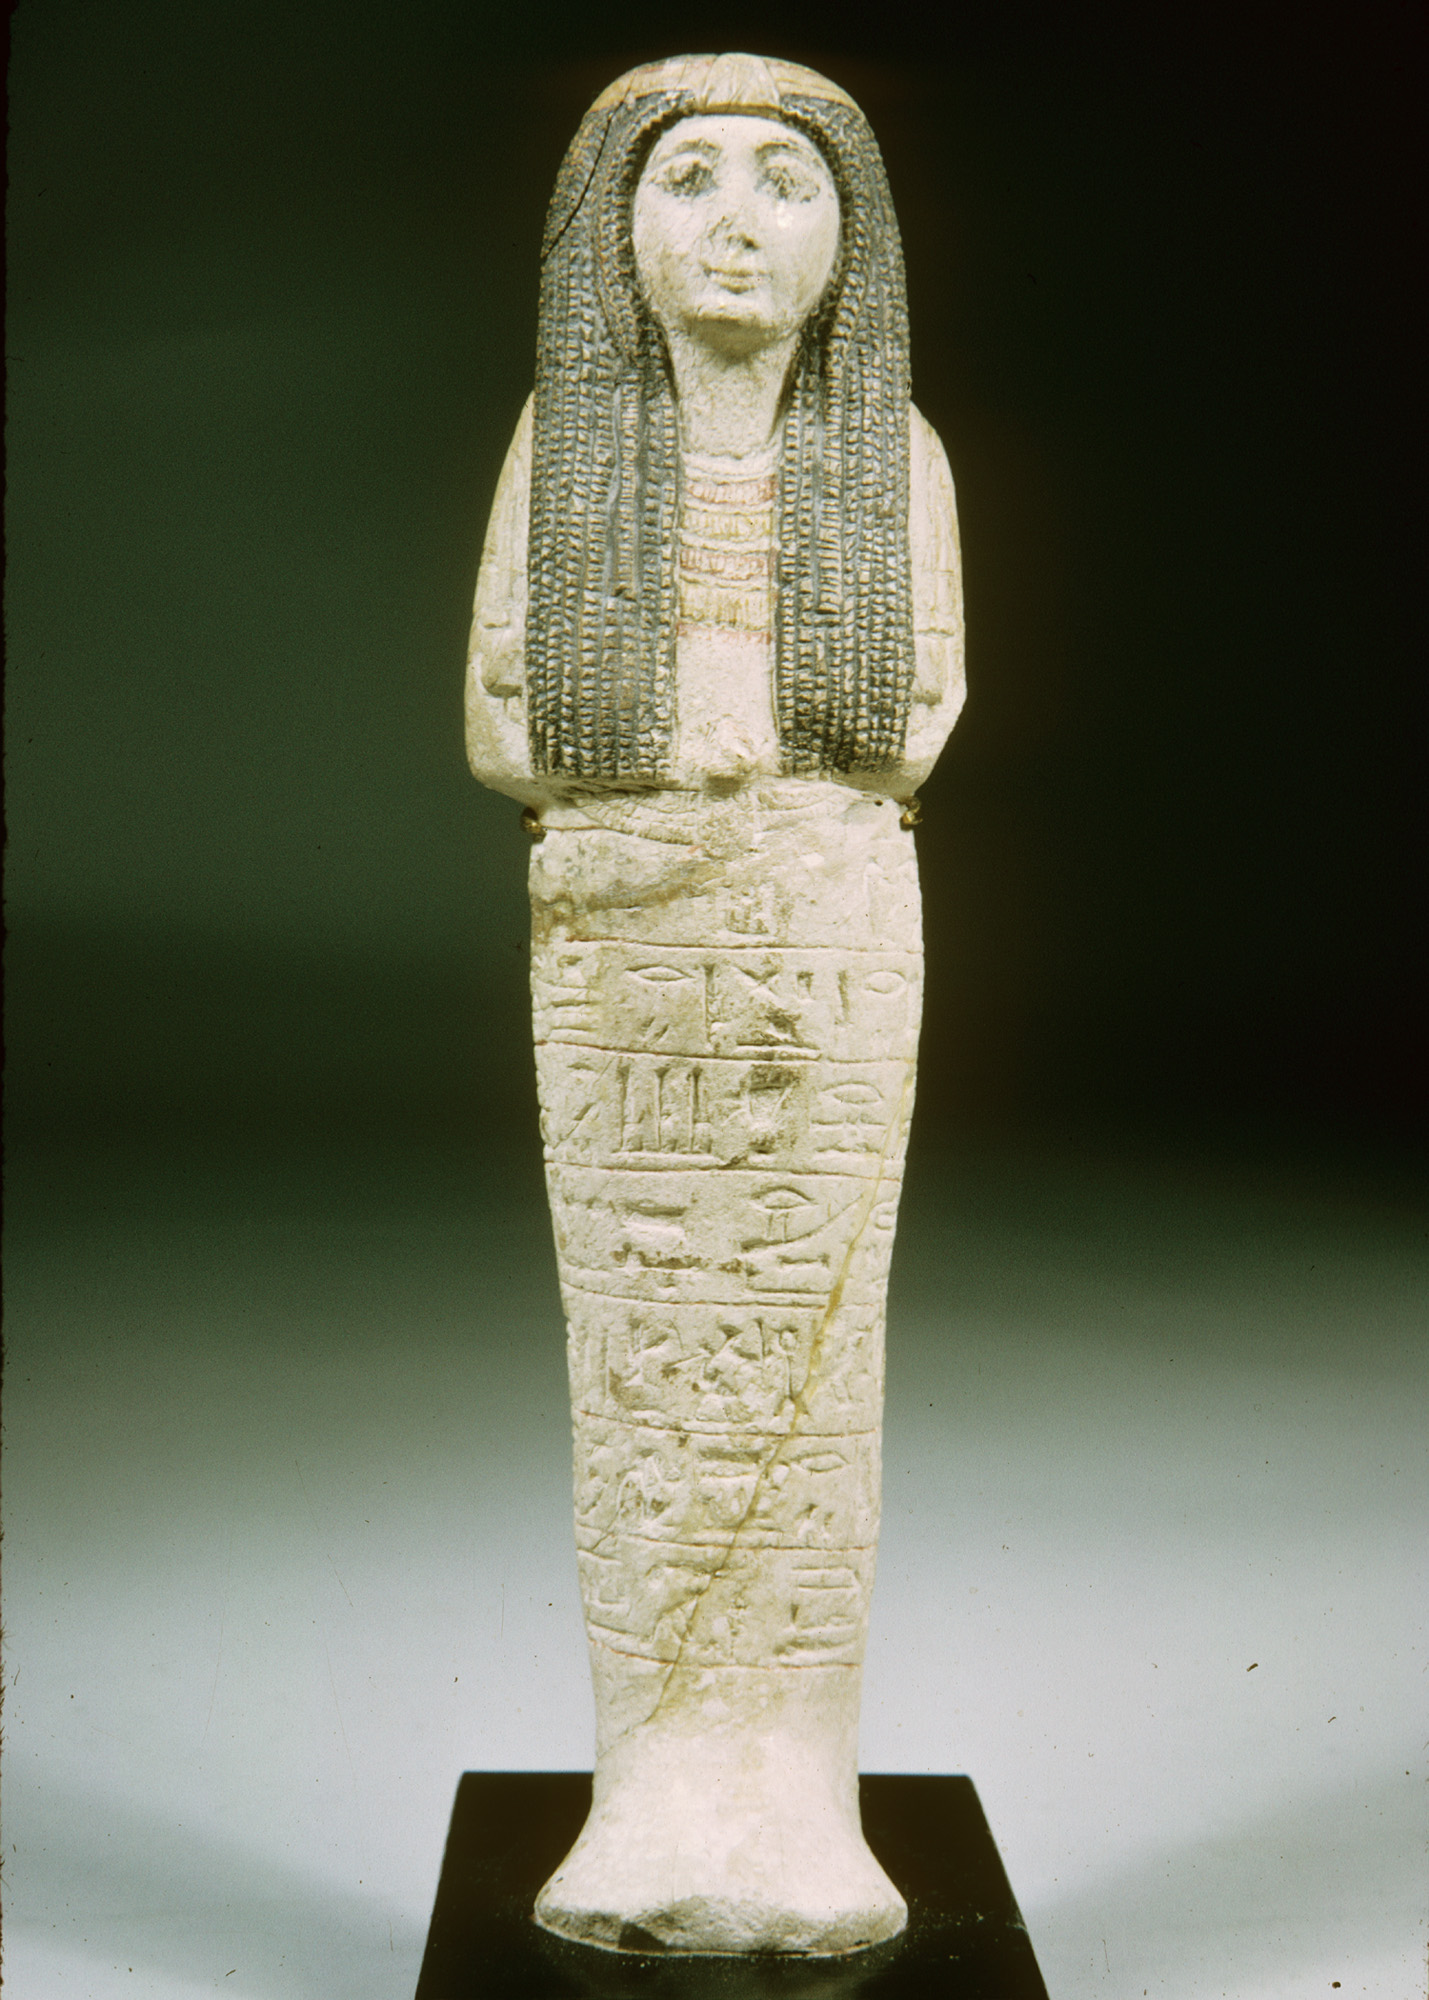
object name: shabti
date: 1295-1070 BCE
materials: limestone, paint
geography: egypt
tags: hieroglyphs